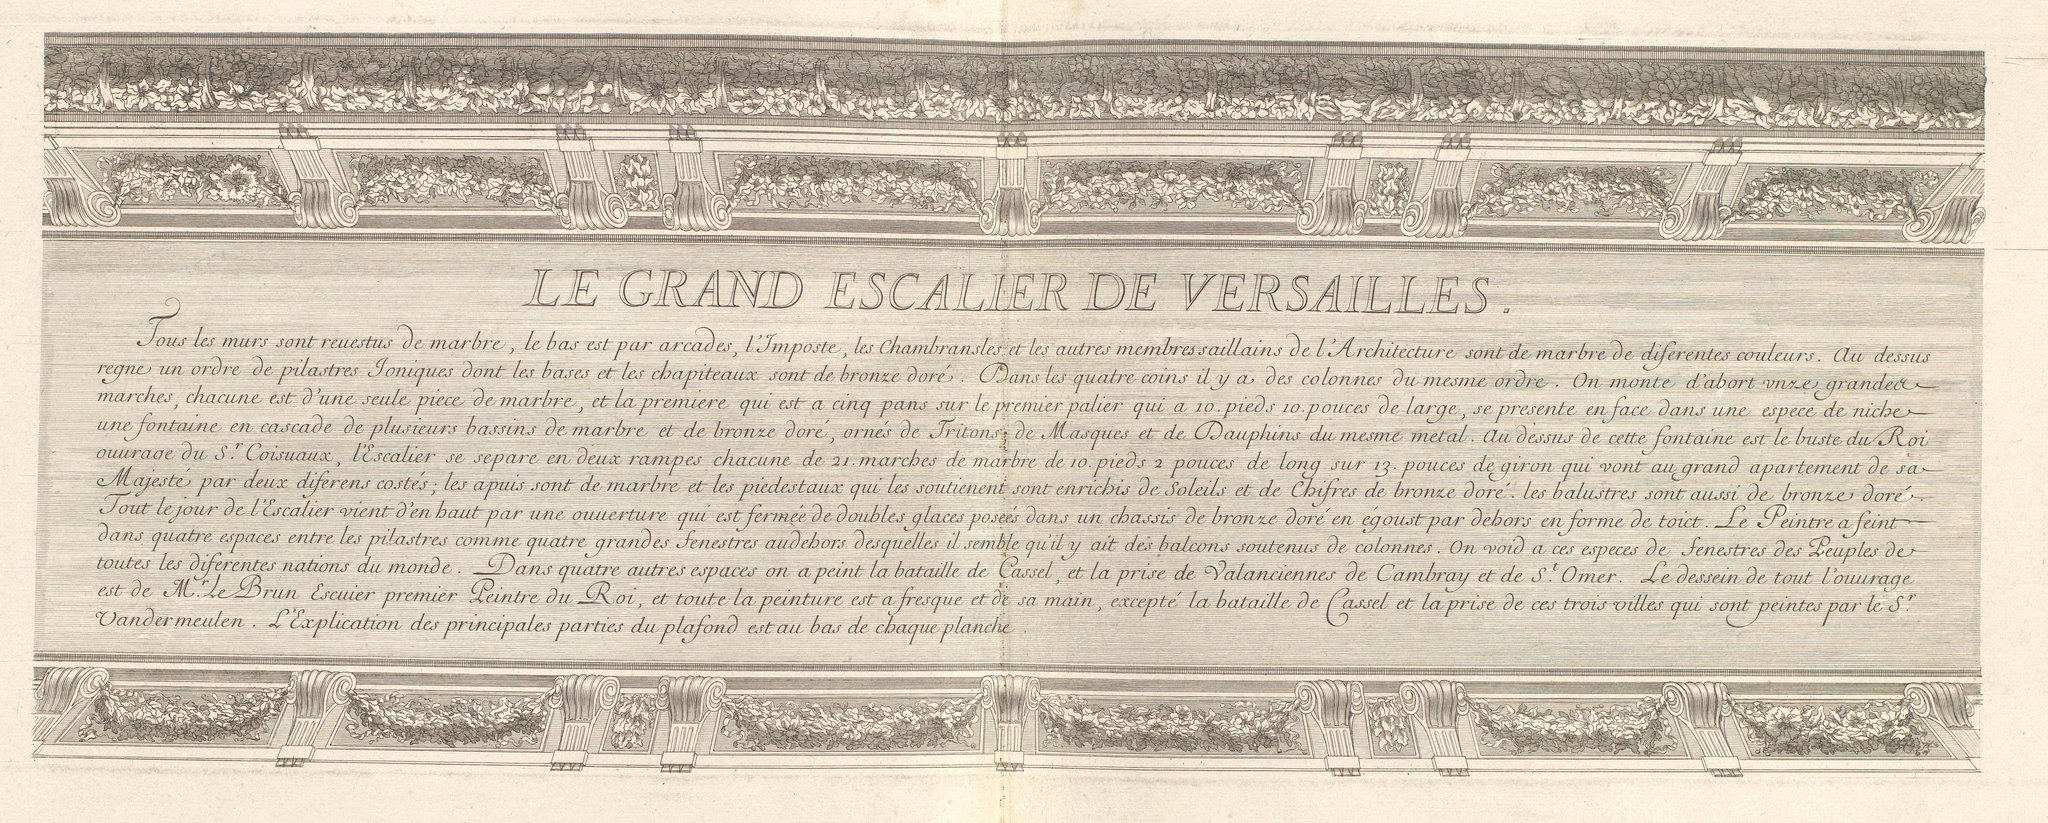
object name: titelprent, frontispice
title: Grand Escalier du Chateau de Versailles dit Escalier des Ambassadeurs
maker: etienne baudet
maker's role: print maker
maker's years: 1638-1711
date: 1648-1711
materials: paper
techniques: engraving, etching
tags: ornaments ~ art, title-page, (decorated) ceiling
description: Centraal gedeelte van het plafond van de Escalier des Ambassadeurs in het Paleis van Versailles, met elf regels tekst. Deze prent maakt deel uit van een album.